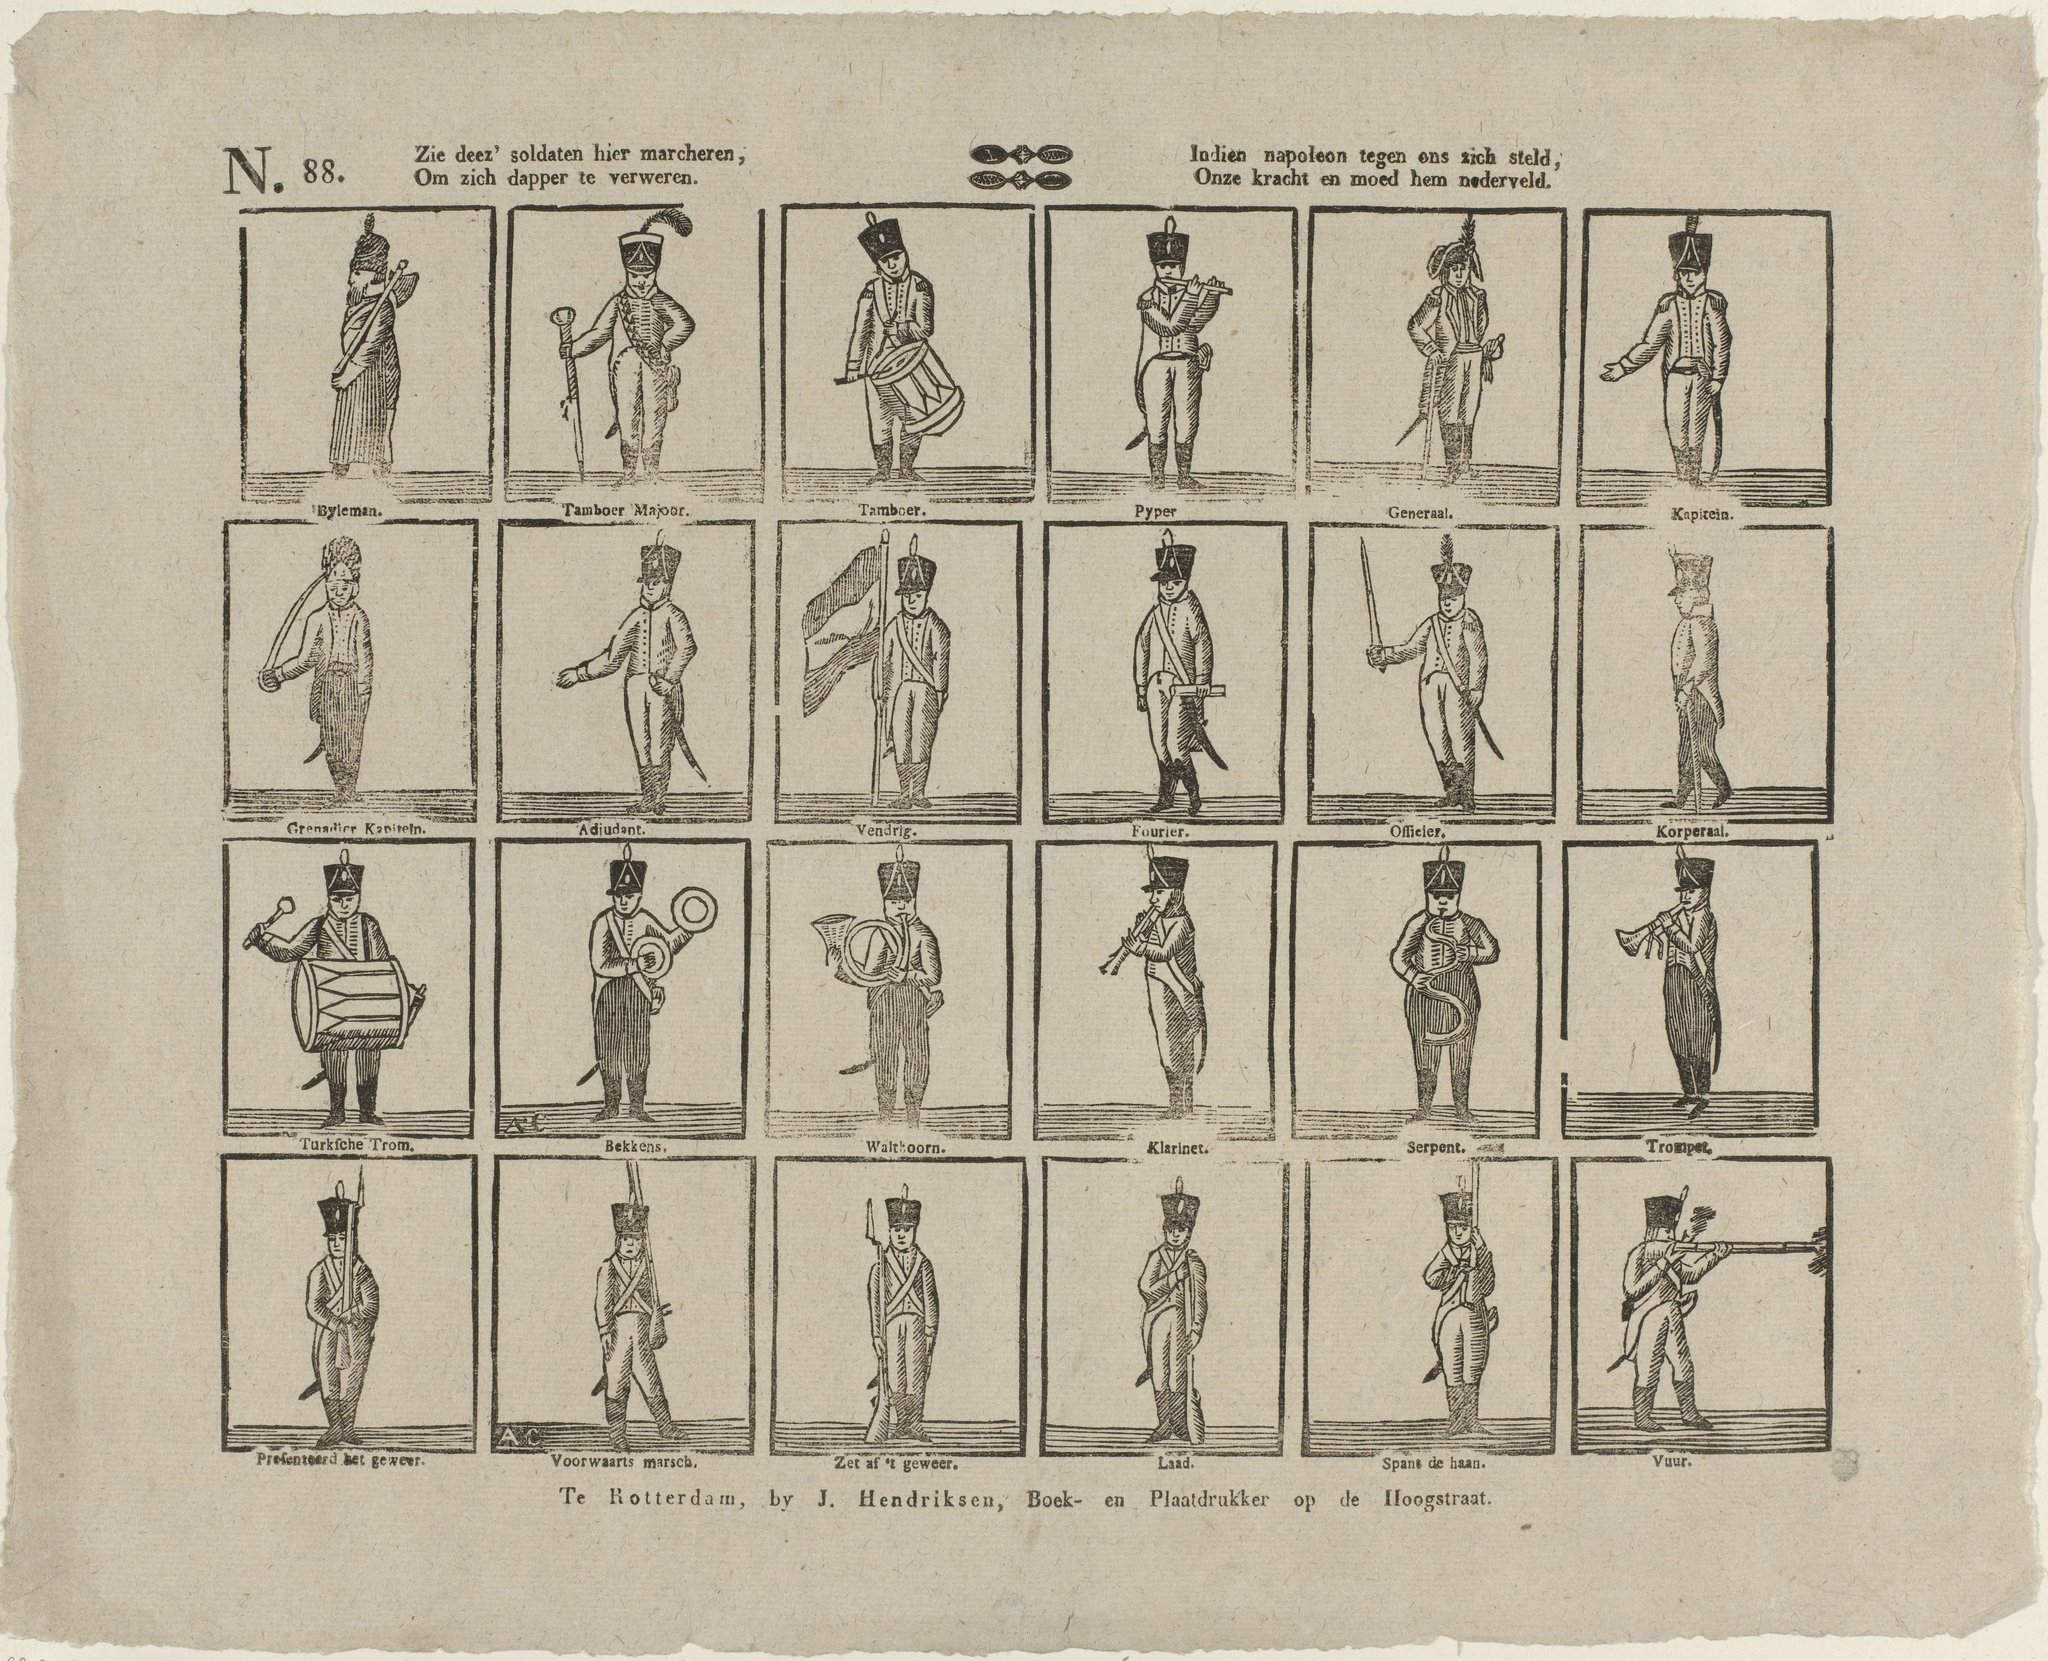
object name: print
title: Zie deez' soldaten hier marcheren, / Om zich dapper te verweren. / Indien napoleon tegen ons zich steld, / Onze kracht en moed hem nederveld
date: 1781-1828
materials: paper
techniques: letterpress printing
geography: rotterdam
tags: military band, weapons, the soldier; the soldier's life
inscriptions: collector's mark: Lugt 2760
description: Blad met 24 voorstellingen van militairen met wapens, vlaggen en muziekinstrumenten. Onder elke afbeelding een onderschrift. Genummerd linksboven: N. 88.